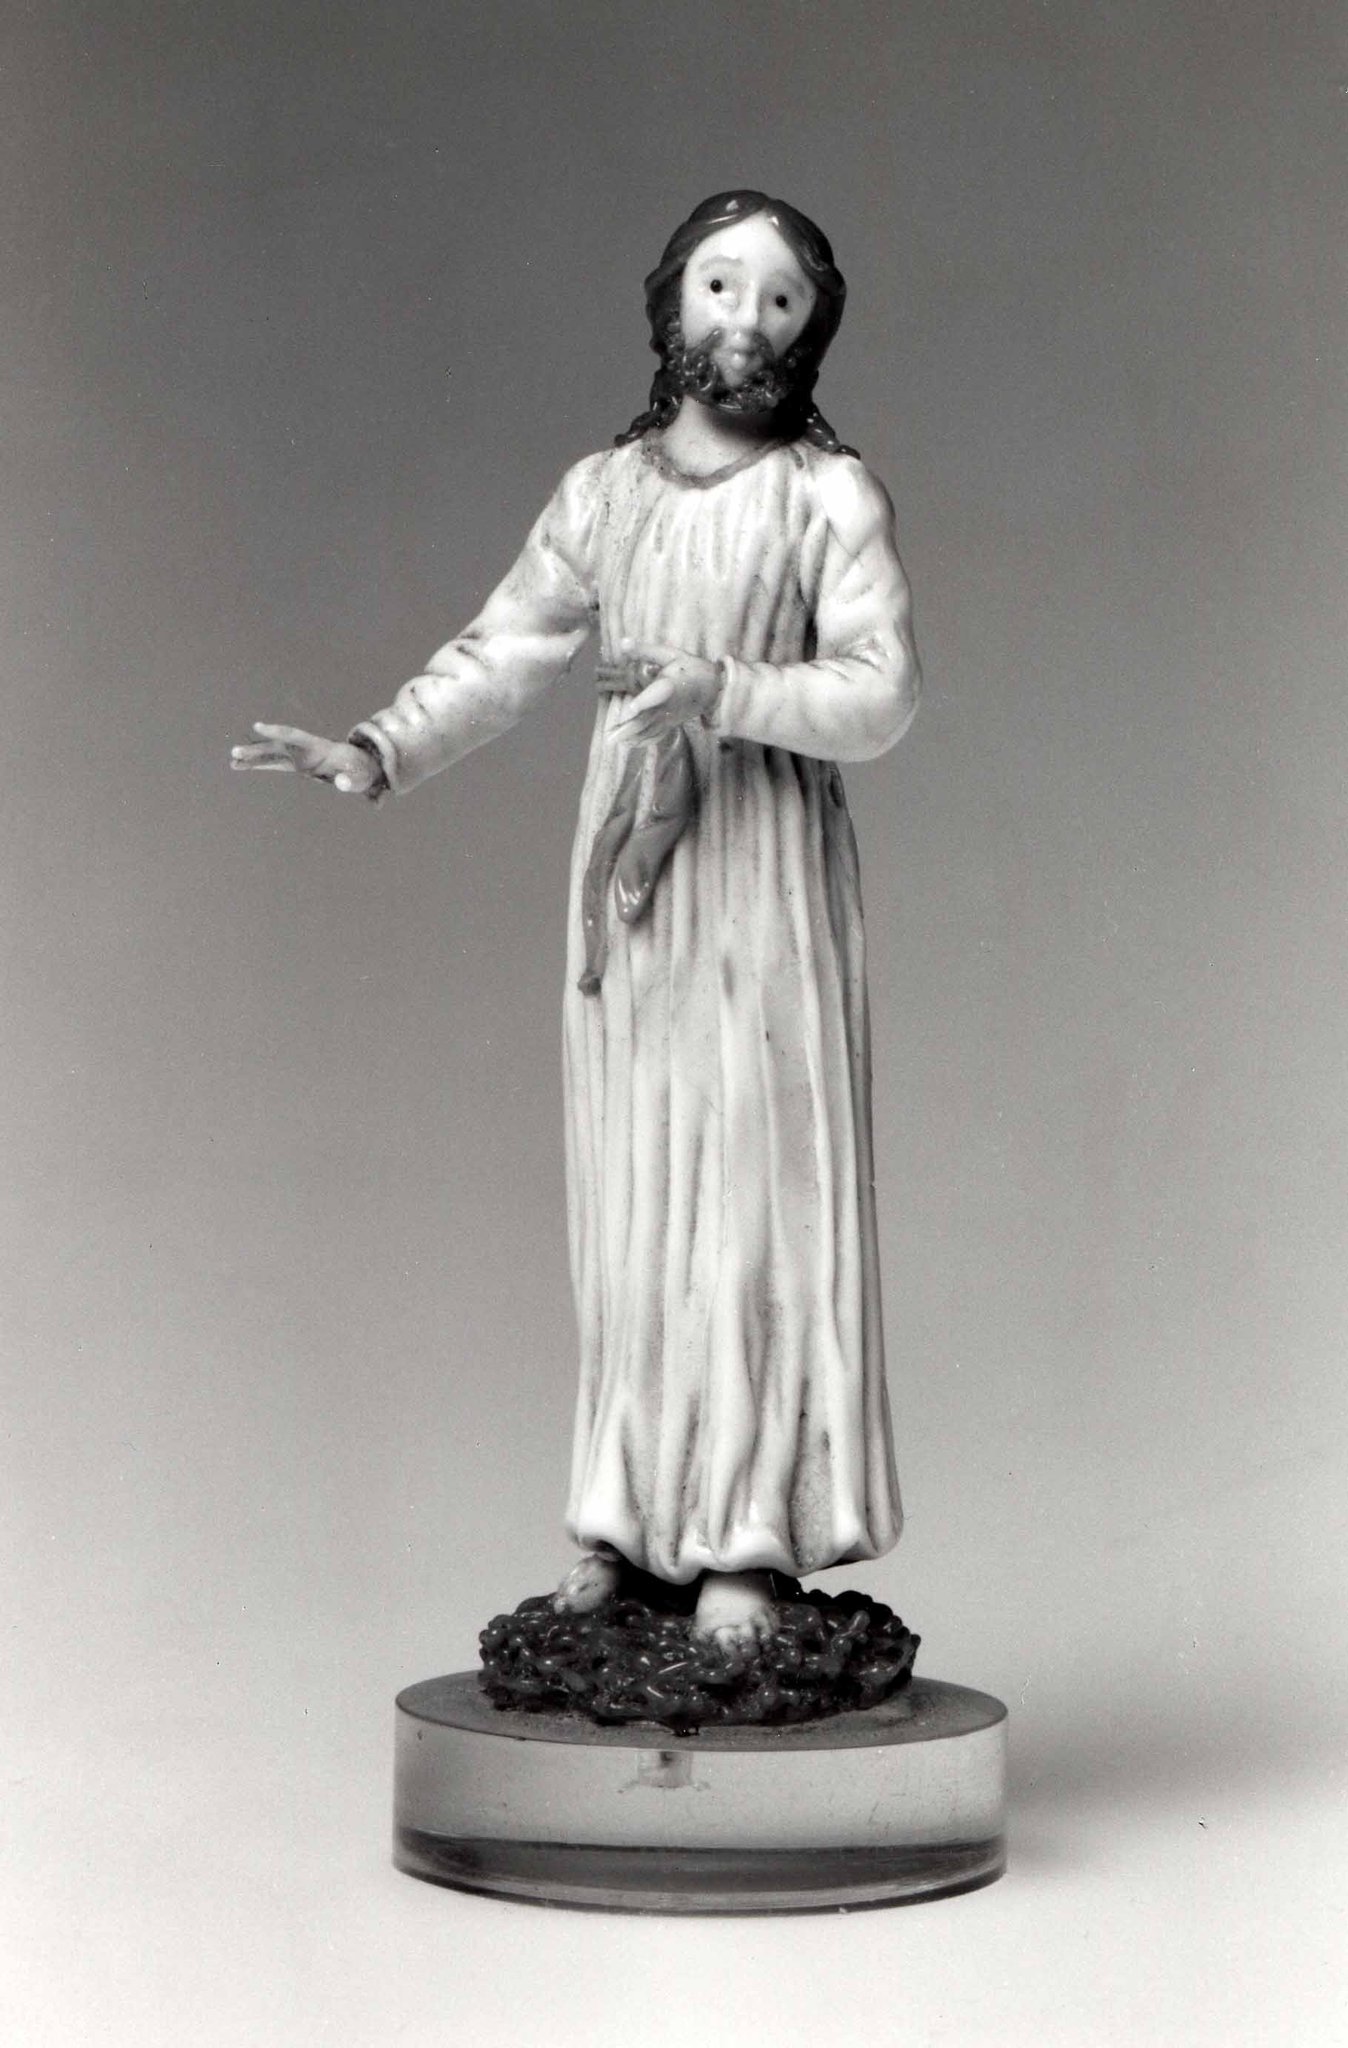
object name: figurine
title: Christ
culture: french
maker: haly workshop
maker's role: artist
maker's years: 18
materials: copper, glass, iron, metal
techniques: lampwork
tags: christ